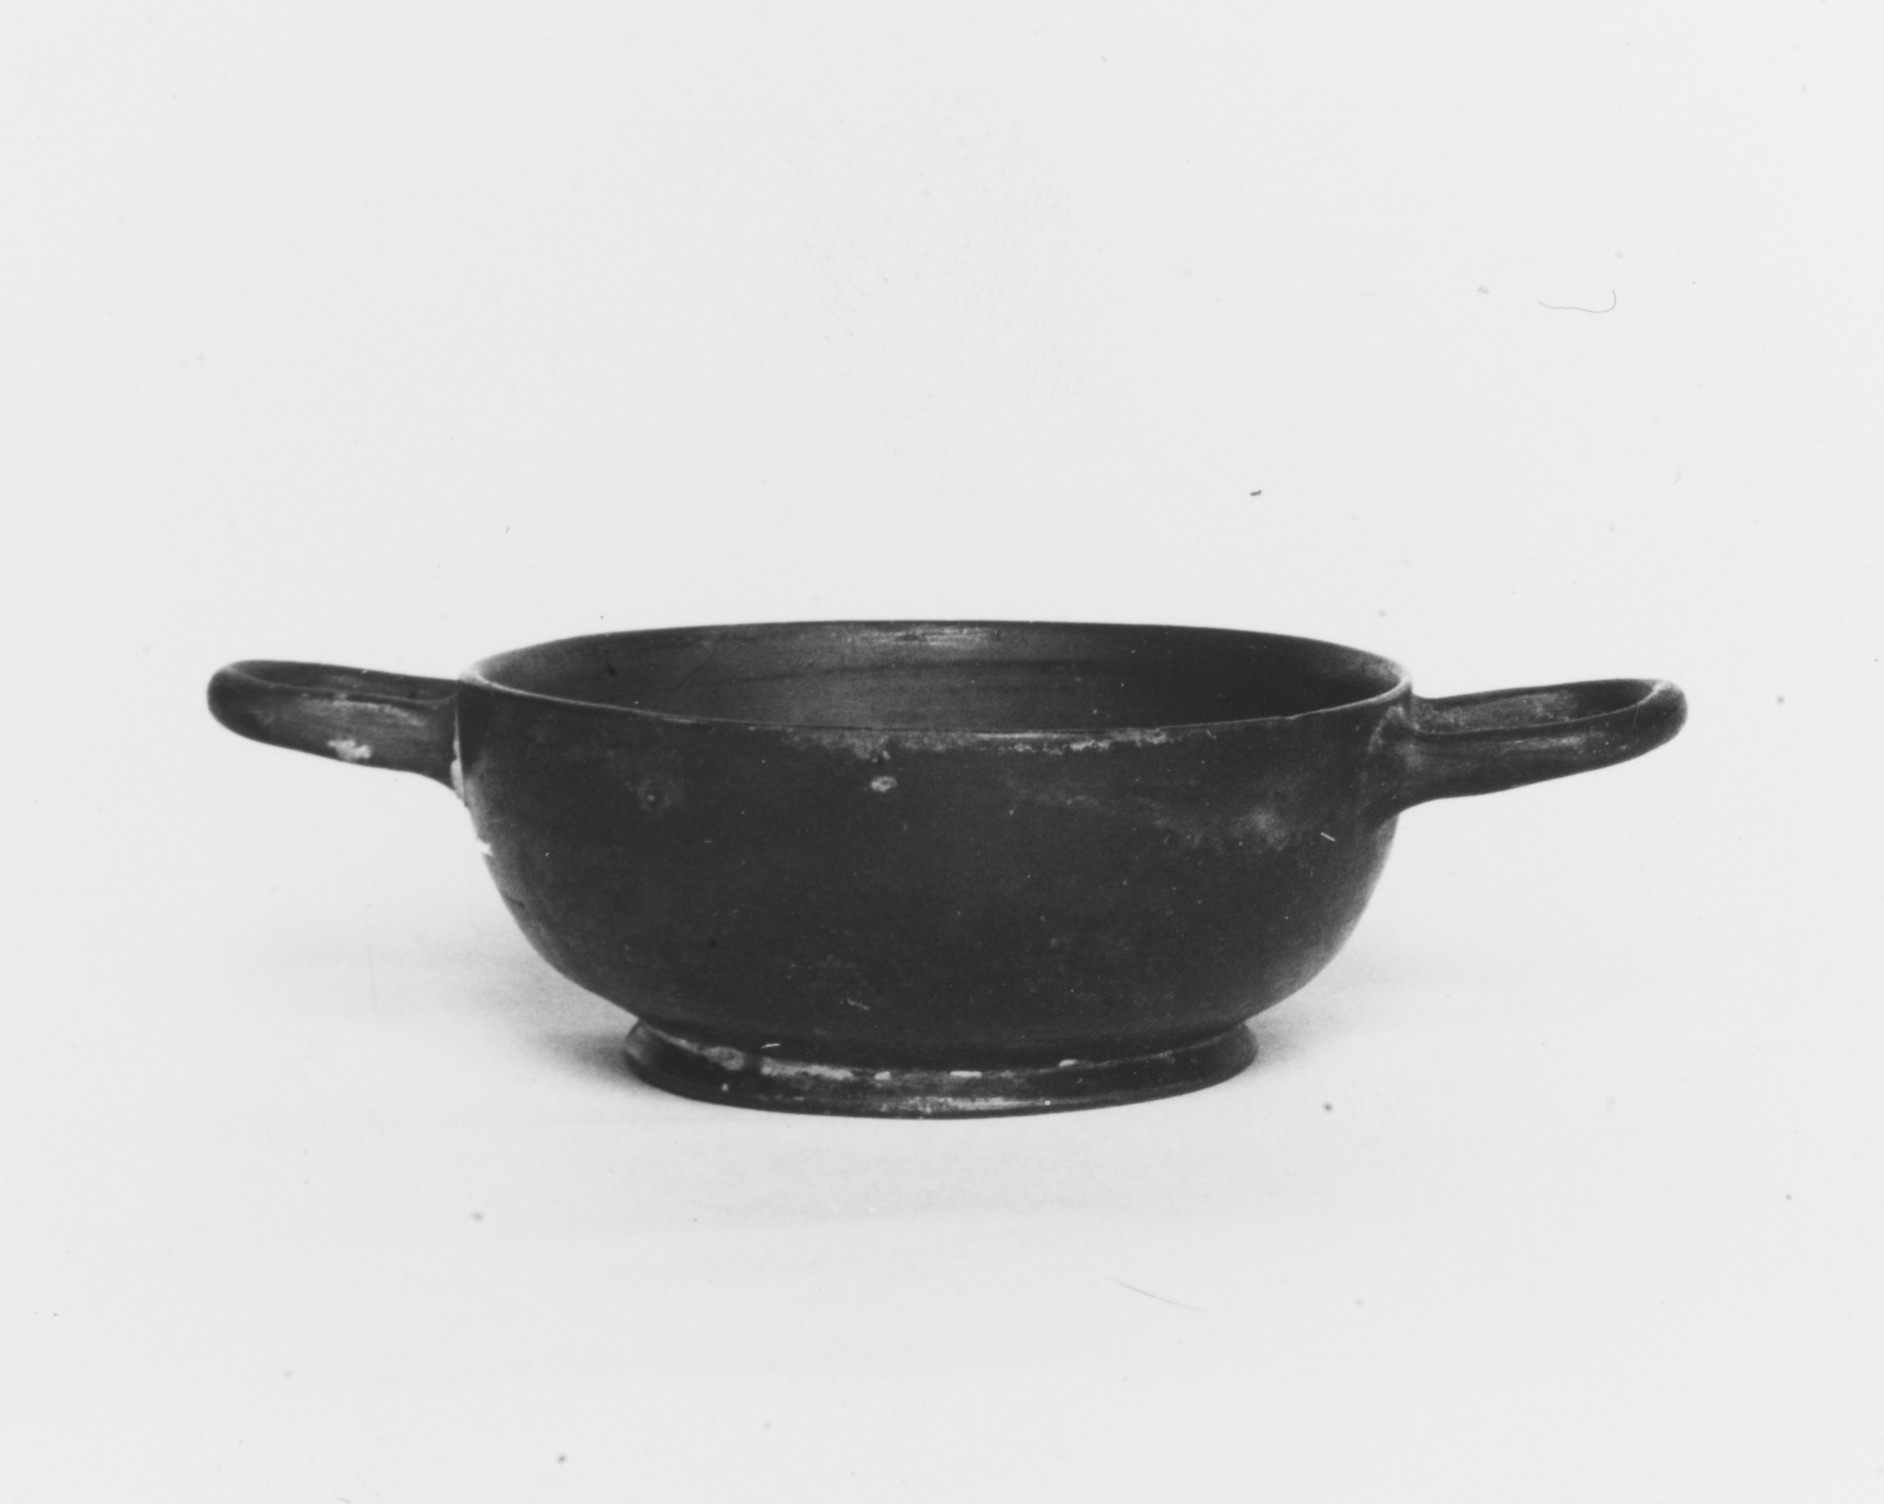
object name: skyphos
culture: greek, attic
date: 434-401 BCE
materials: terracotta